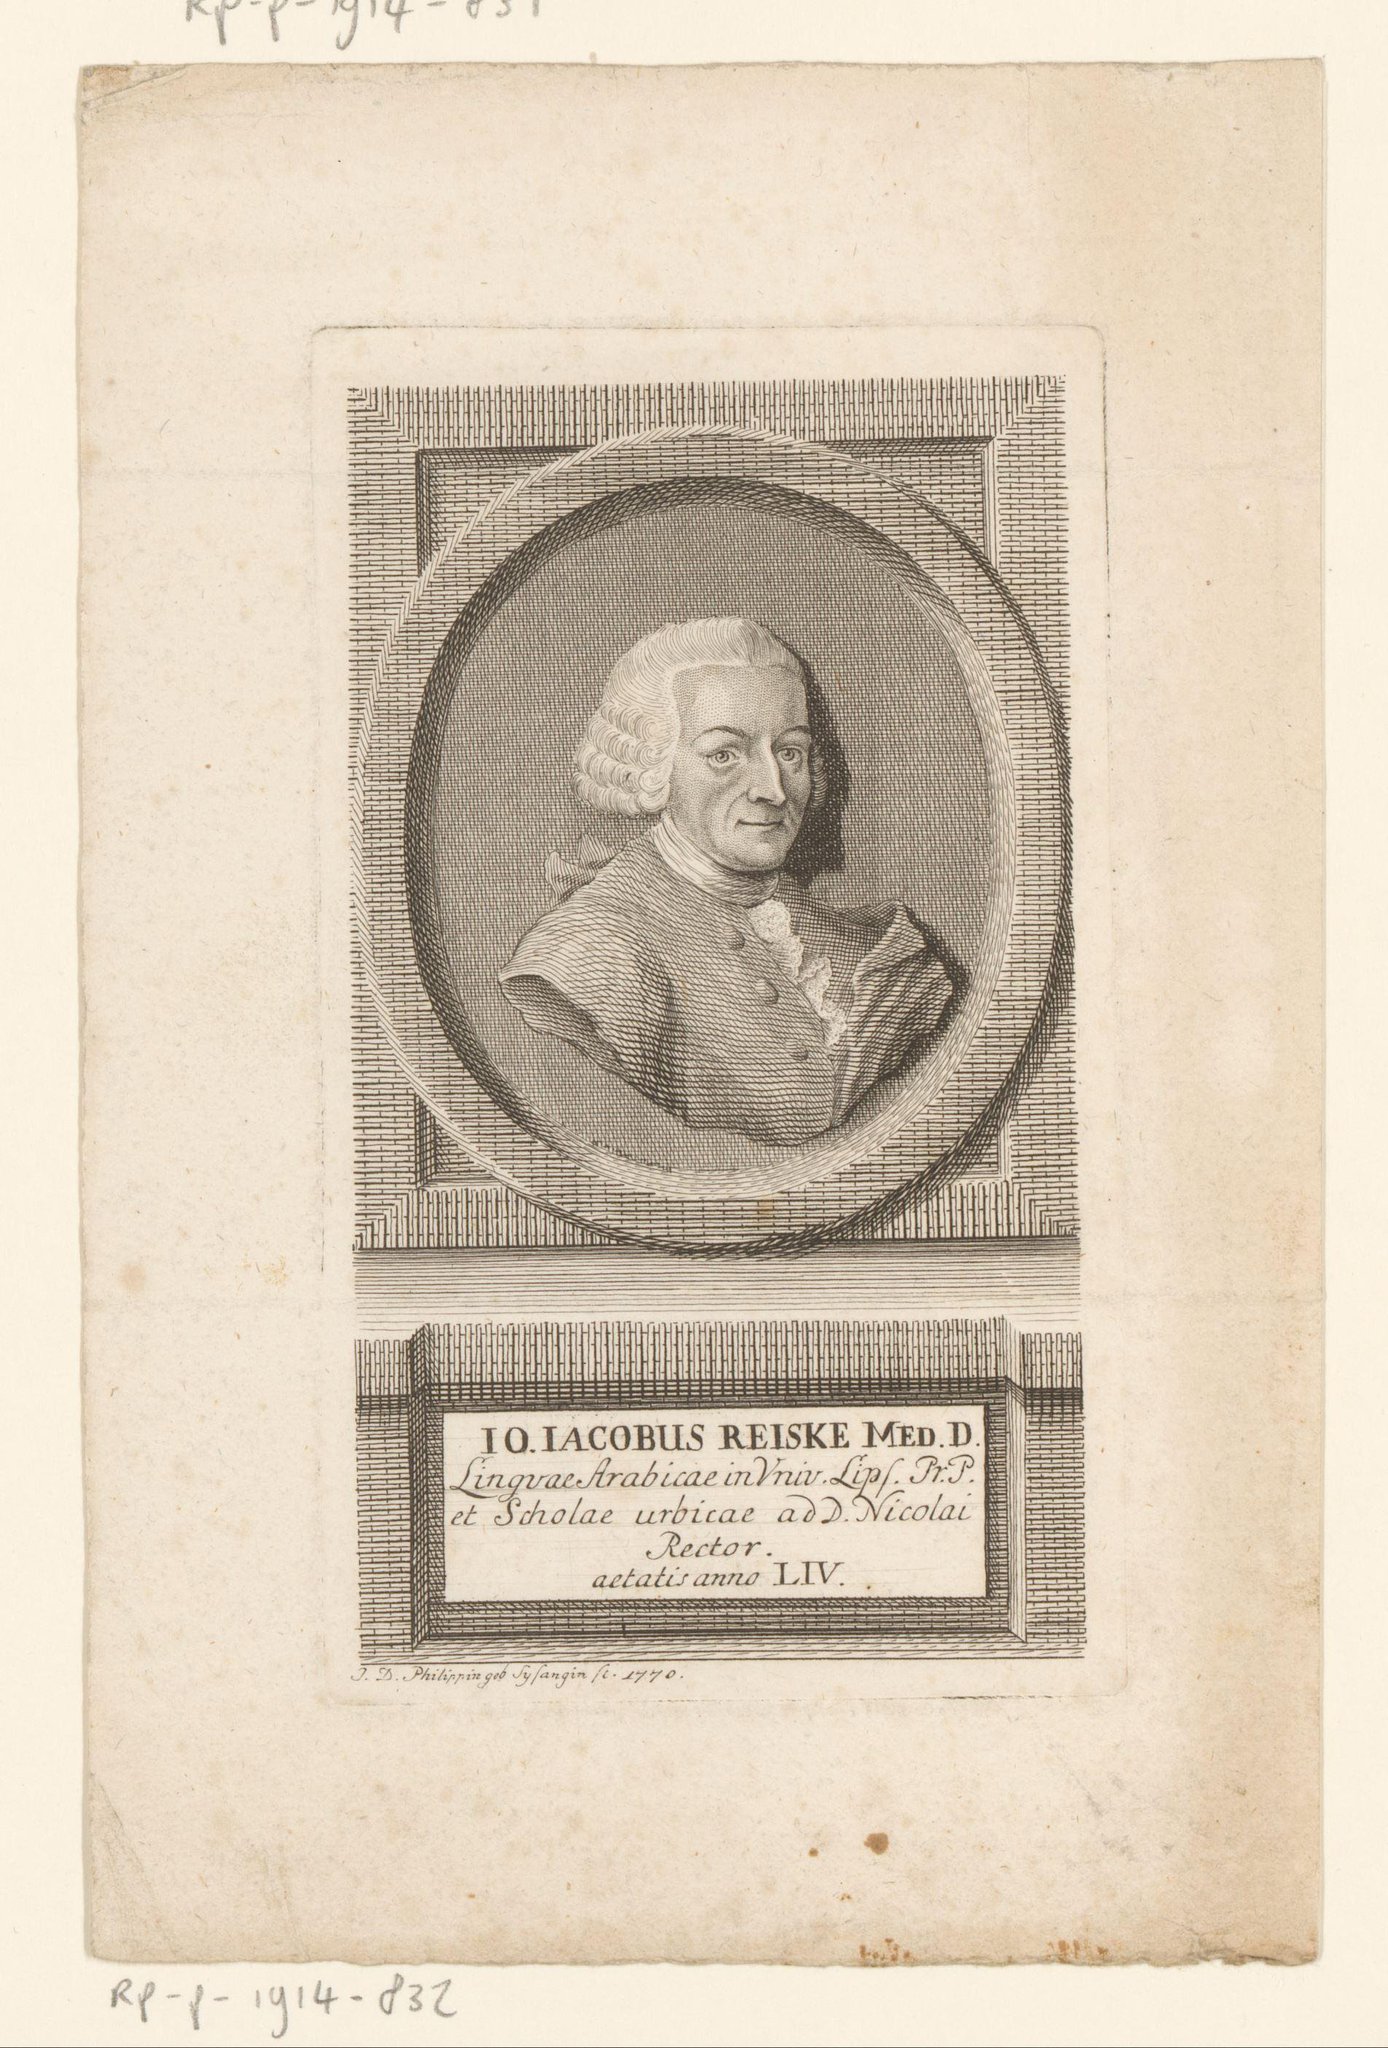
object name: print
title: Portret van Johann Jacob Reiske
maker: johanna dorothea sysang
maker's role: print maker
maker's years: 1729-1791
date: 1770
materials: paper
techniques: engraving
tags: historical persons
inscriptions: collector's mark: Lugt 2228